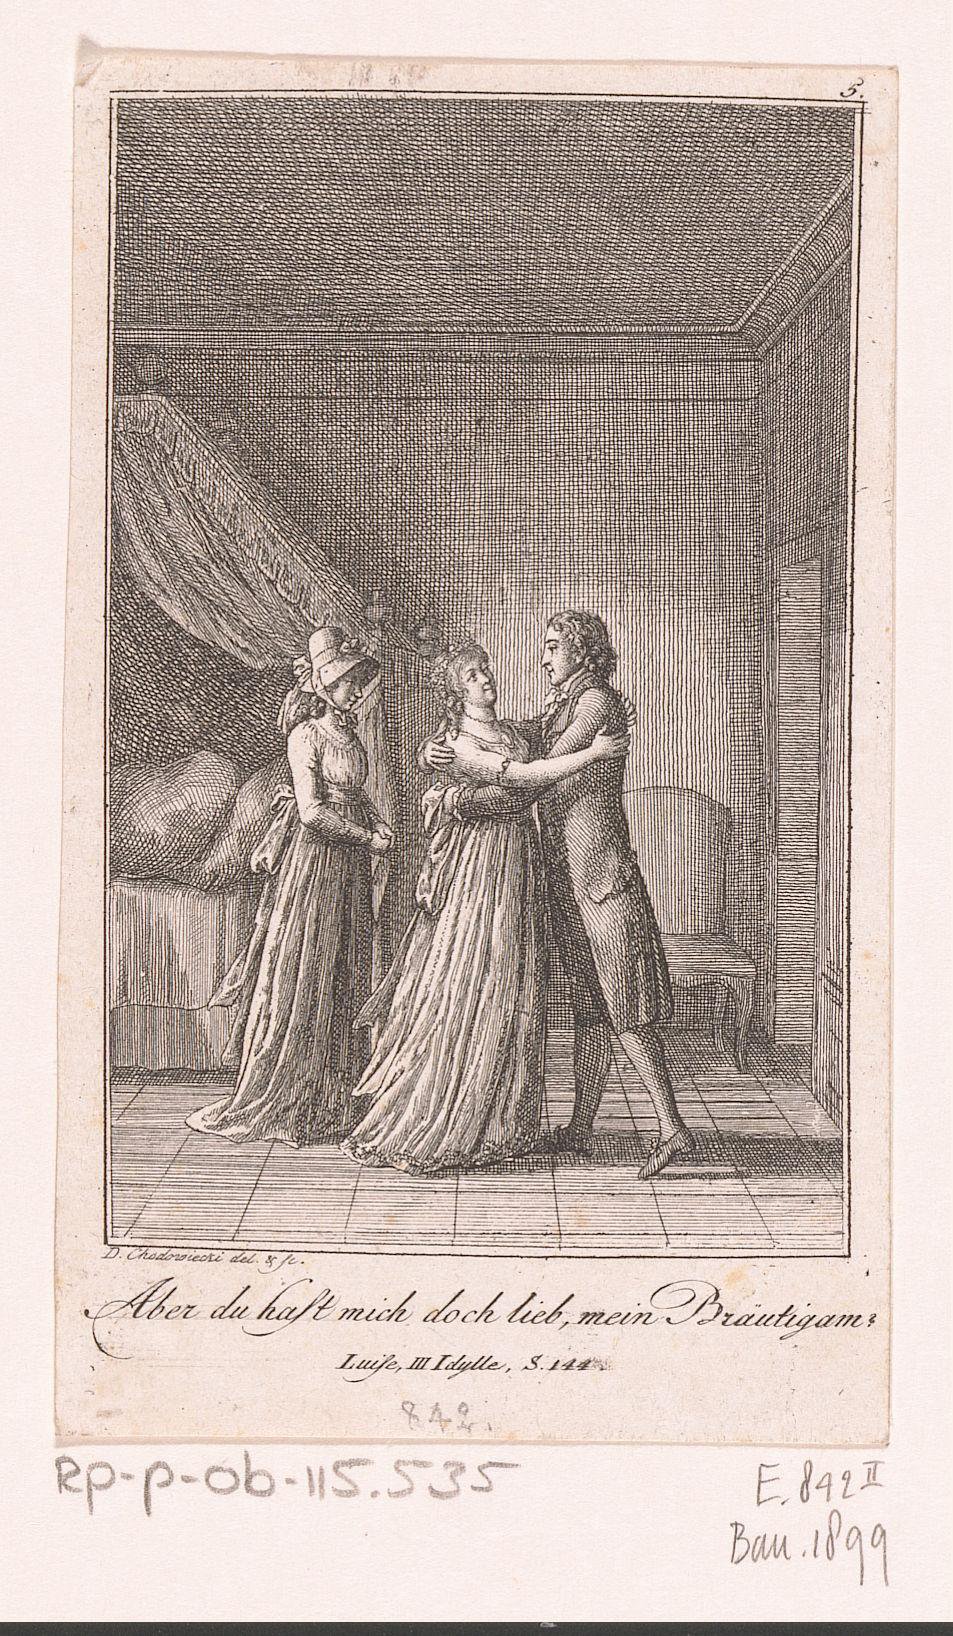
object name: print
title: Walter ziet Luise in haar bruidsjurk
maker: daniel nikolaus chodowiecki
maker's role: draughtsman, print maker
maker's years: 1726-1801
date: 1797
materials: paper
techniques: etching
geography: berlin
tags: literature, (lovers) embracing each other, 'symplegma', bedroom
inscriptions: collector's mark: Lugt 2228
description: Prent gebruikt voor: Becker, Wilhelm Gottlieb. Almanach und Taschenbuch zum geselligen Vergnügen von W. G. Becker für 1798. Leipzig: Voss und Comp., [1797].